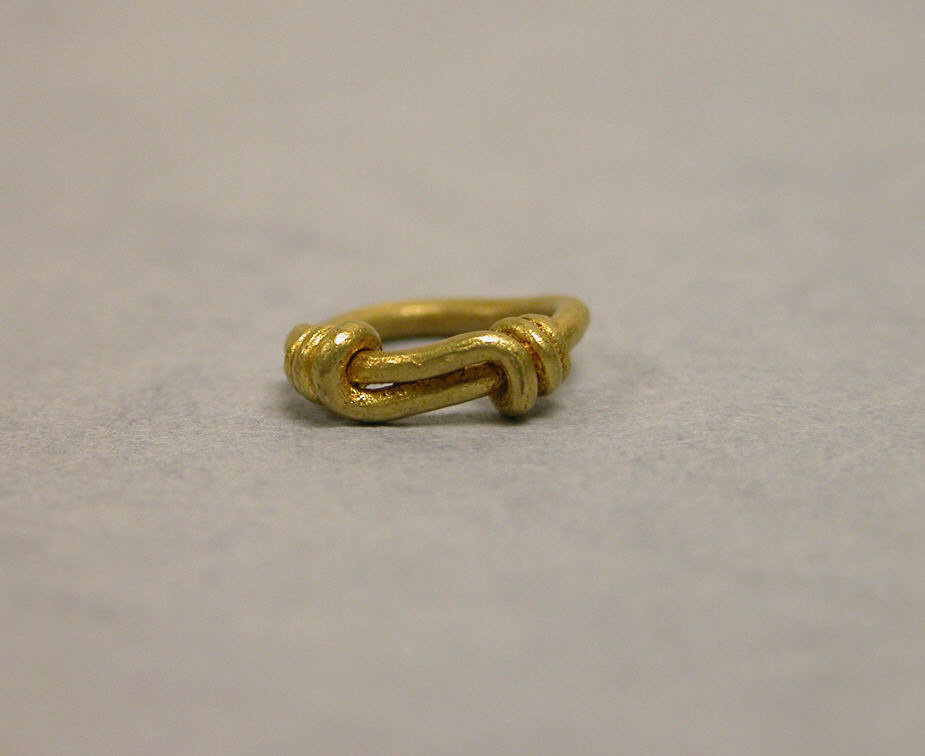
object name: pair of earring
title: Pair of Earrings, Rope Twist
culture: indonesian, central java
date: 701-1200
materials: gold